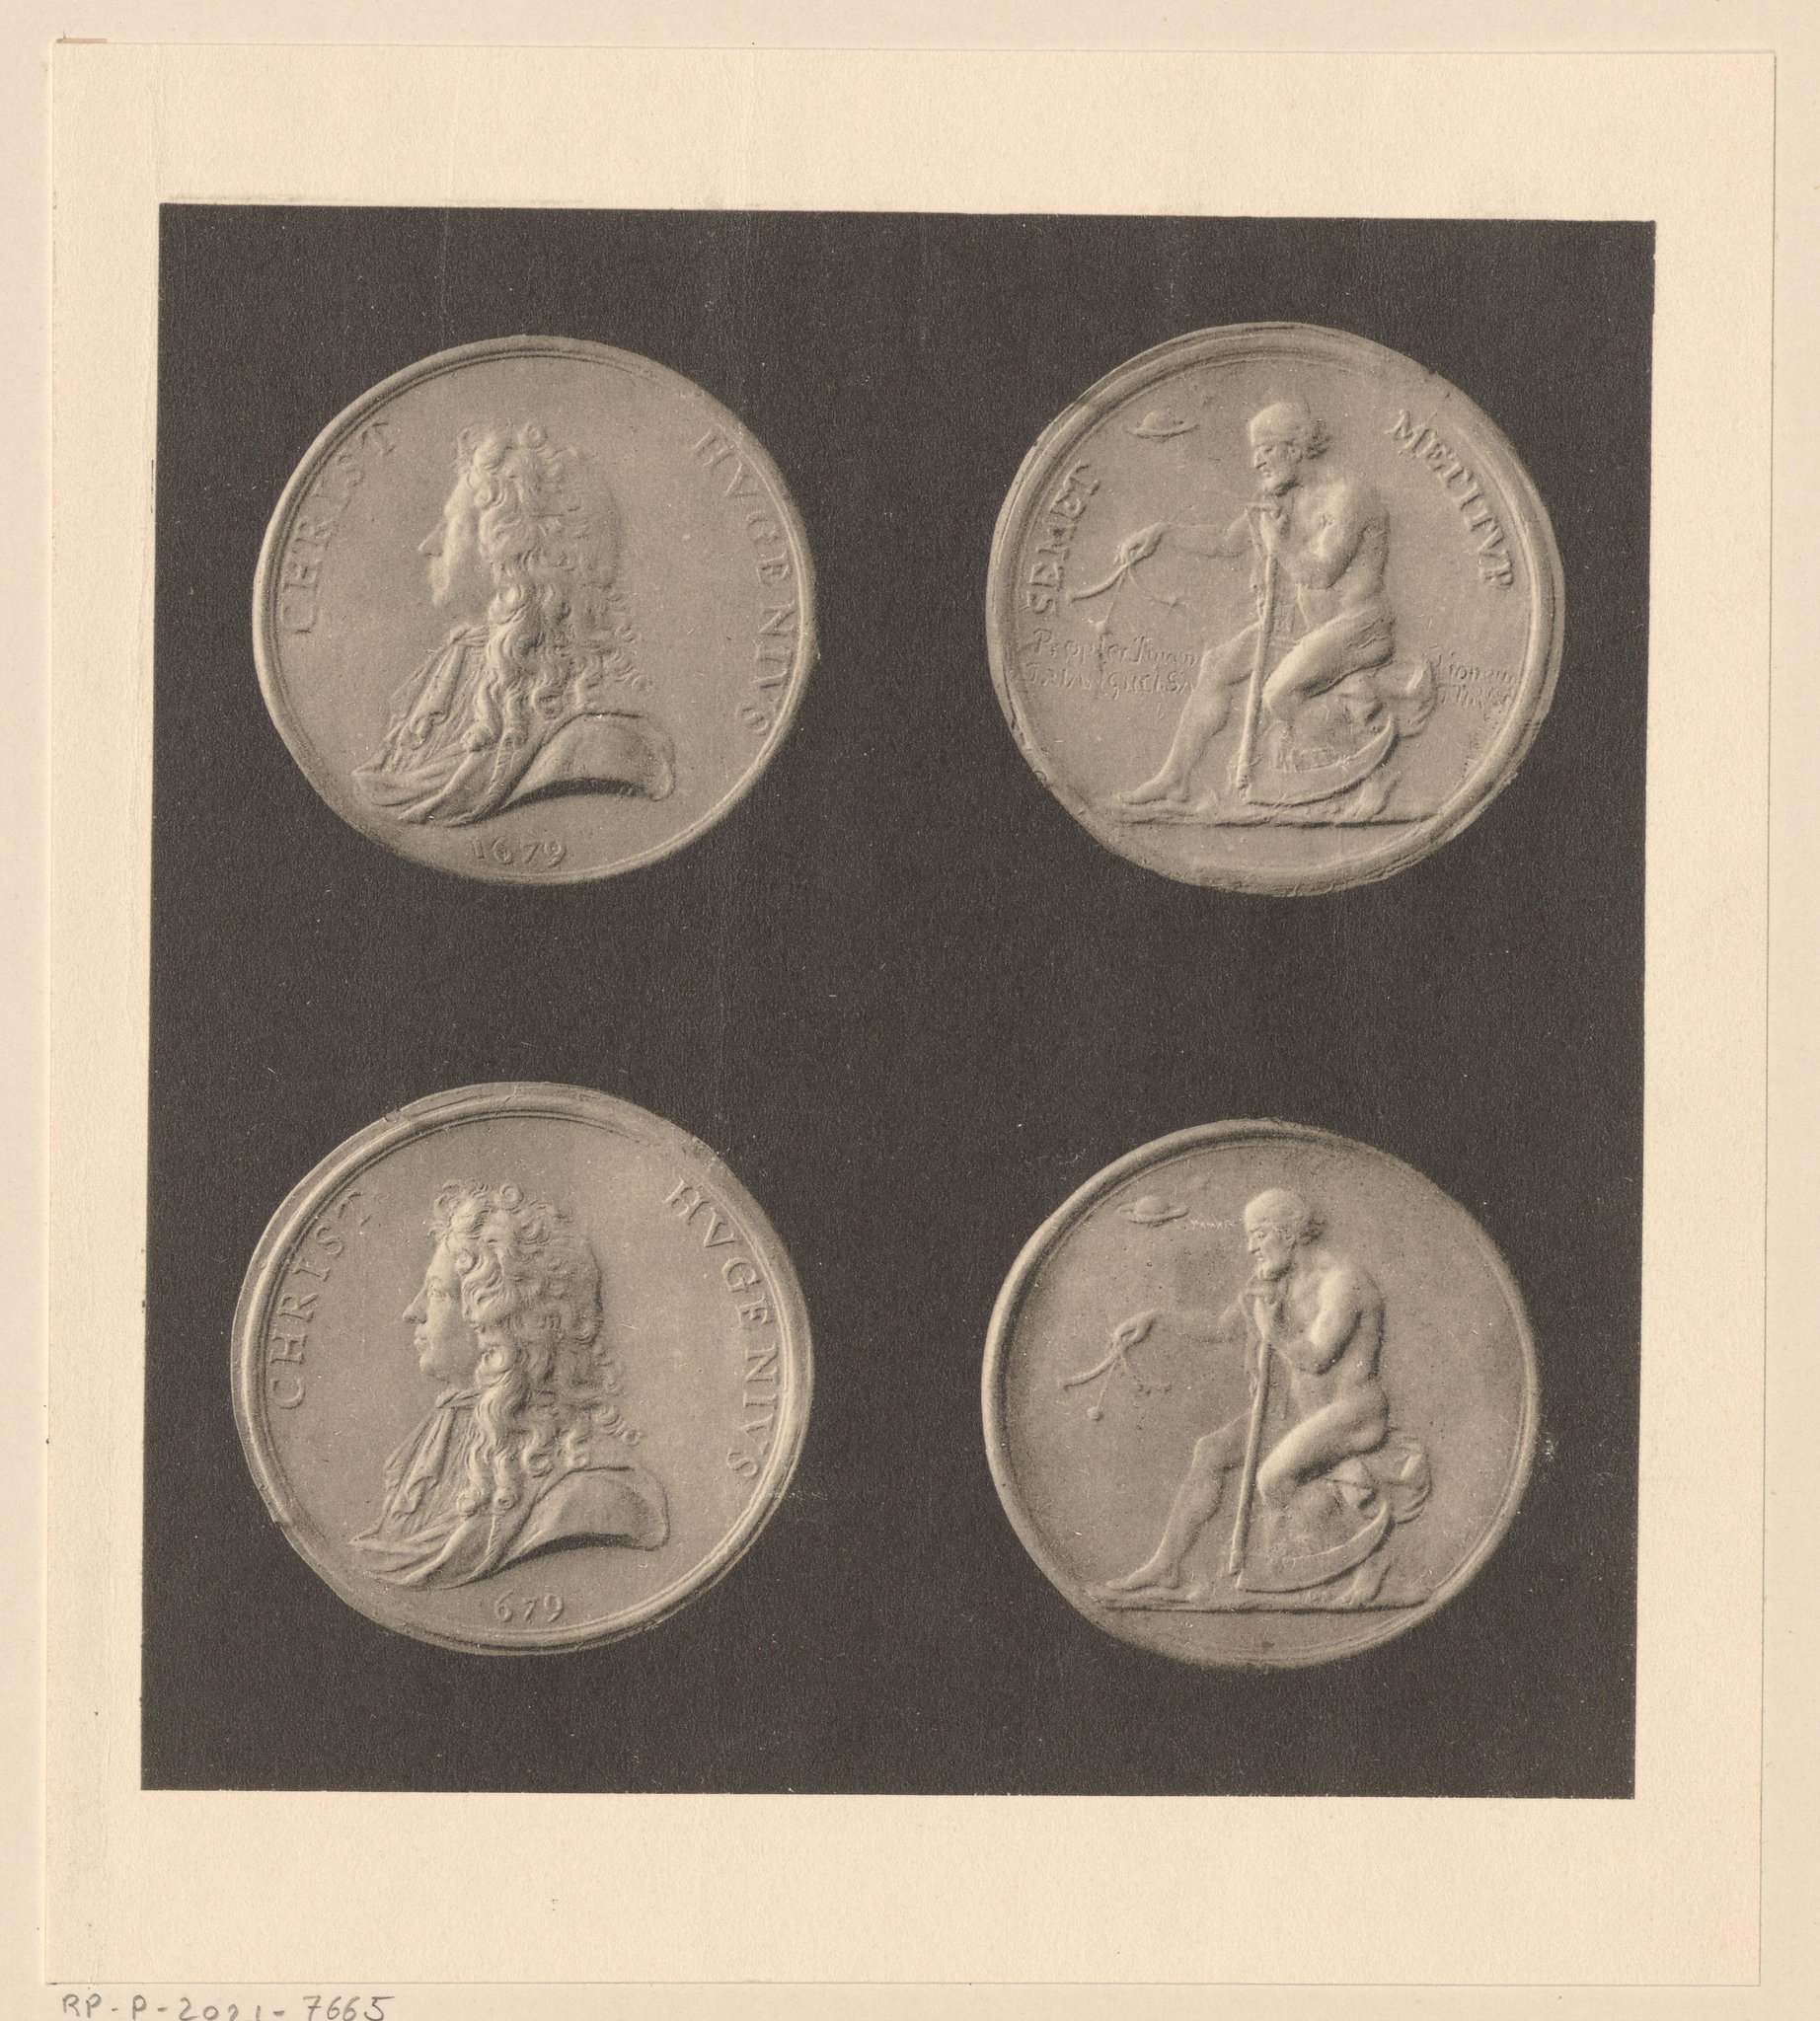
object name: photomechanical print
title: Medaillons met een portret van Christiaan Huygens en Saturnus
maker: Anonymous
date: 1875-1930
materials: paper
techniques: photograph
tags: the hague, draughtsman, physicist, christiaan huygens (ii), astronomy (and cosmography) (+ portrait of scholar, scientist), (story of) saturn (cronus), pendulum (theory), historical persons, medal (considered as a piece of sculpture, regardless of its specific function), mathematics (+ portrait of scholar, scientist), saturn (planet)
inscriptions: collector's mark: Lugt 964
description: Saturnus houdt in zijn hand waarschijnlijk een pendulum.